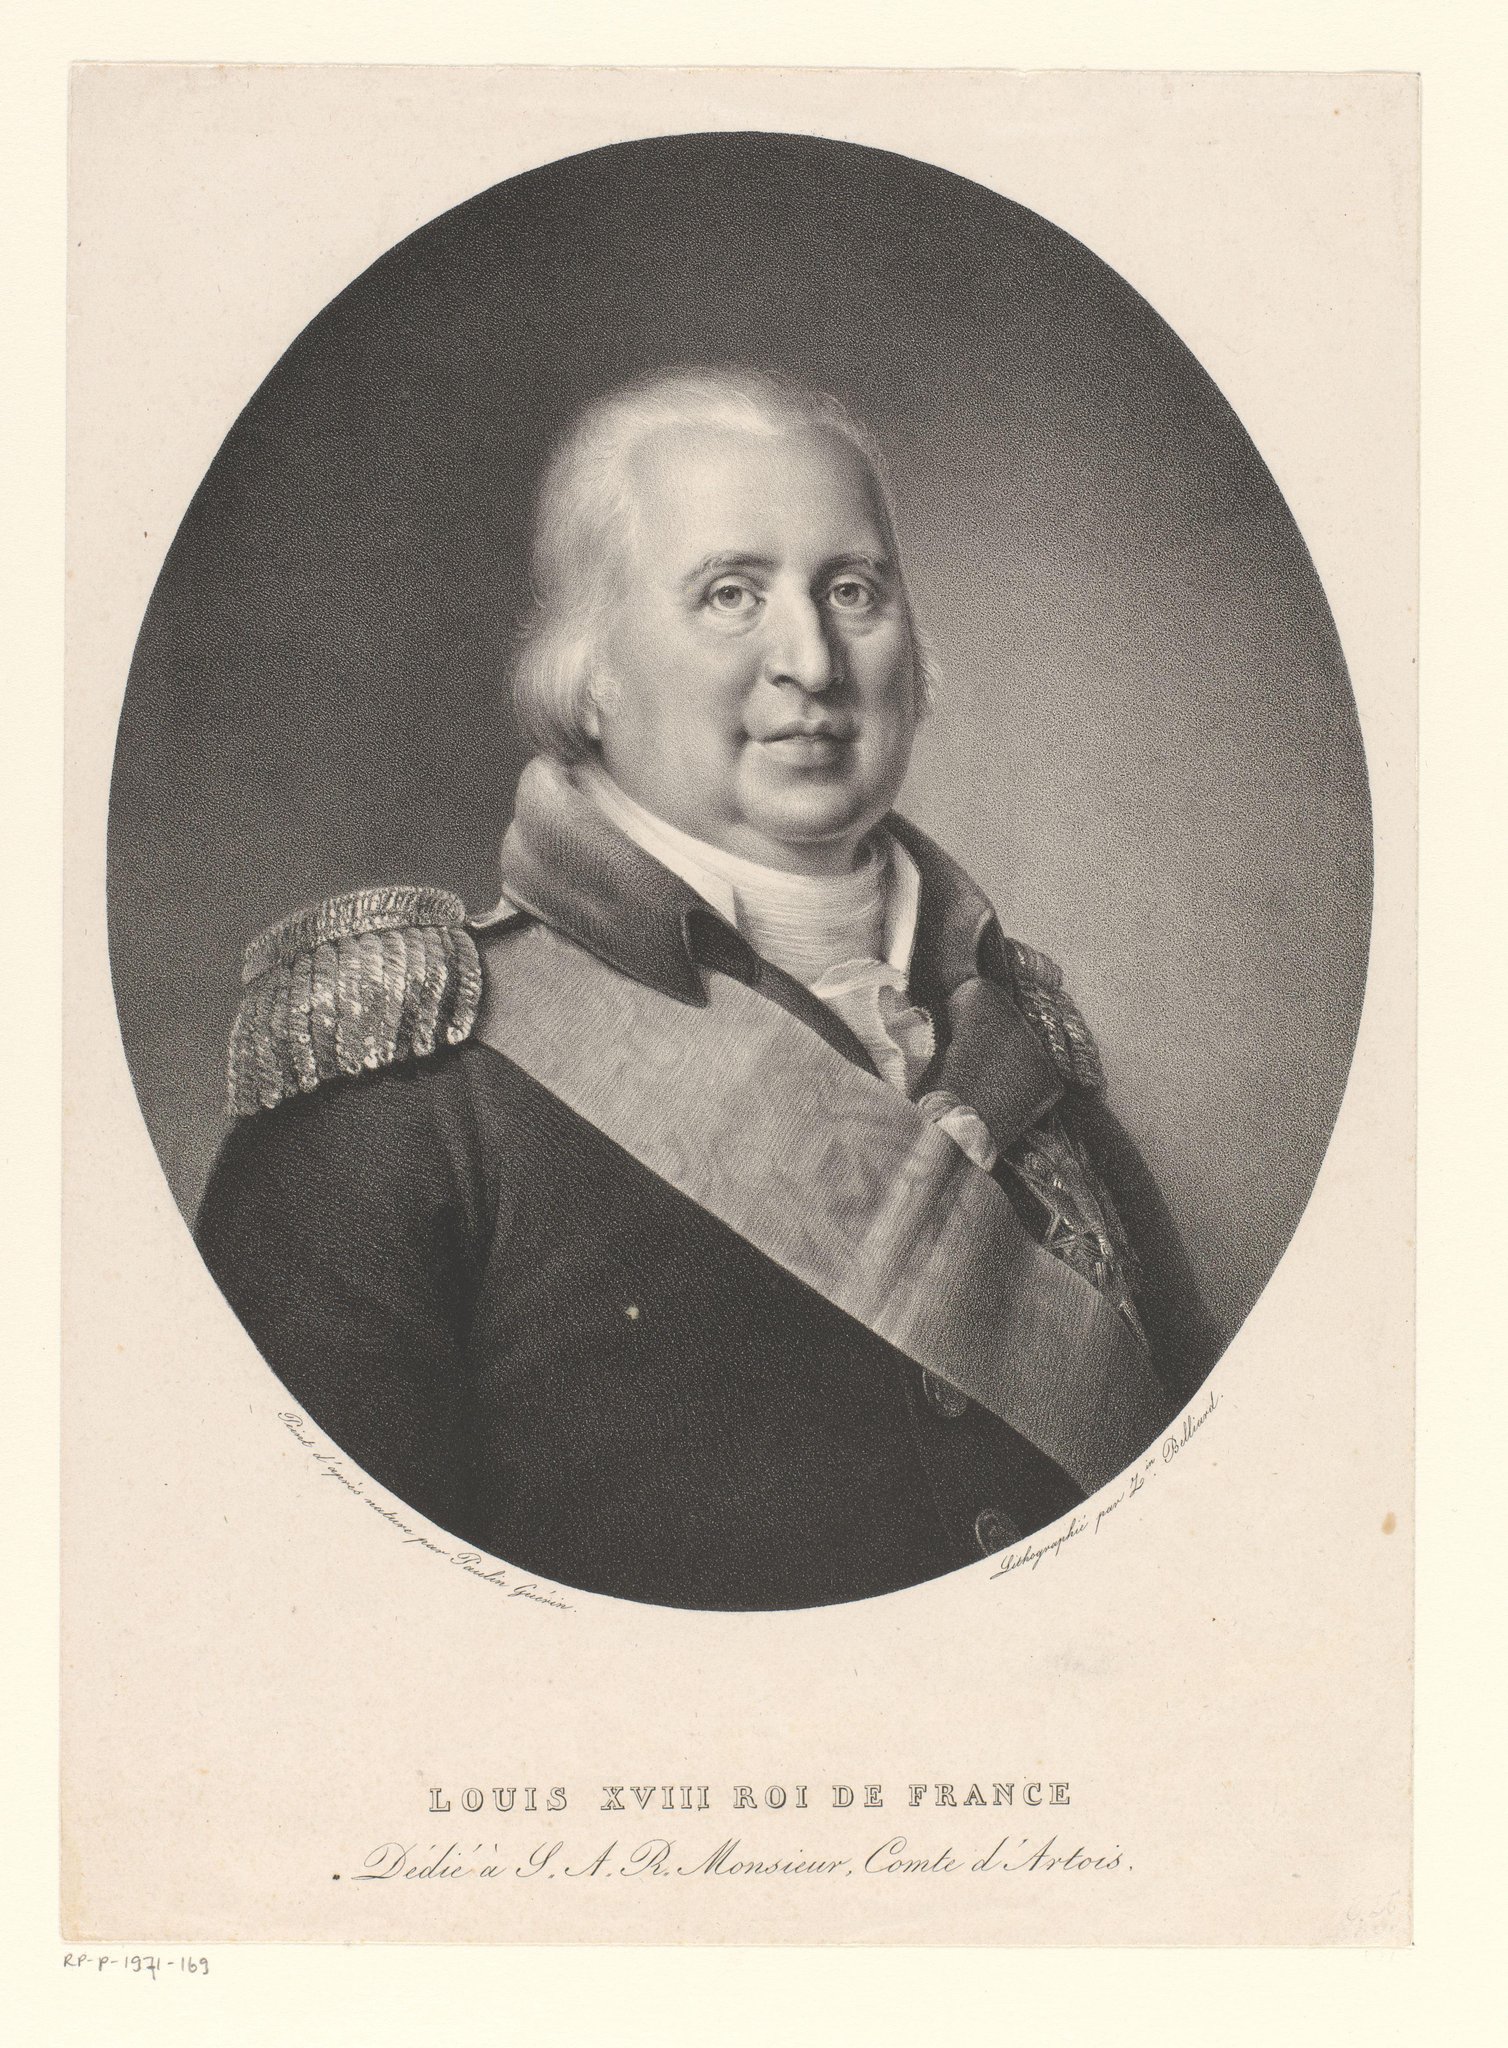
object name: print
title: Portret van Lodewijk XVIII van Frankrijk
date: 1824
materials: paper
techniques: lithograph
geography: paris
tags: lodewijk xviii (koning van frankrijk), historical persons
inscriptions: collector's mark: Lugt 2228a, collector's mark: Lugt 2760